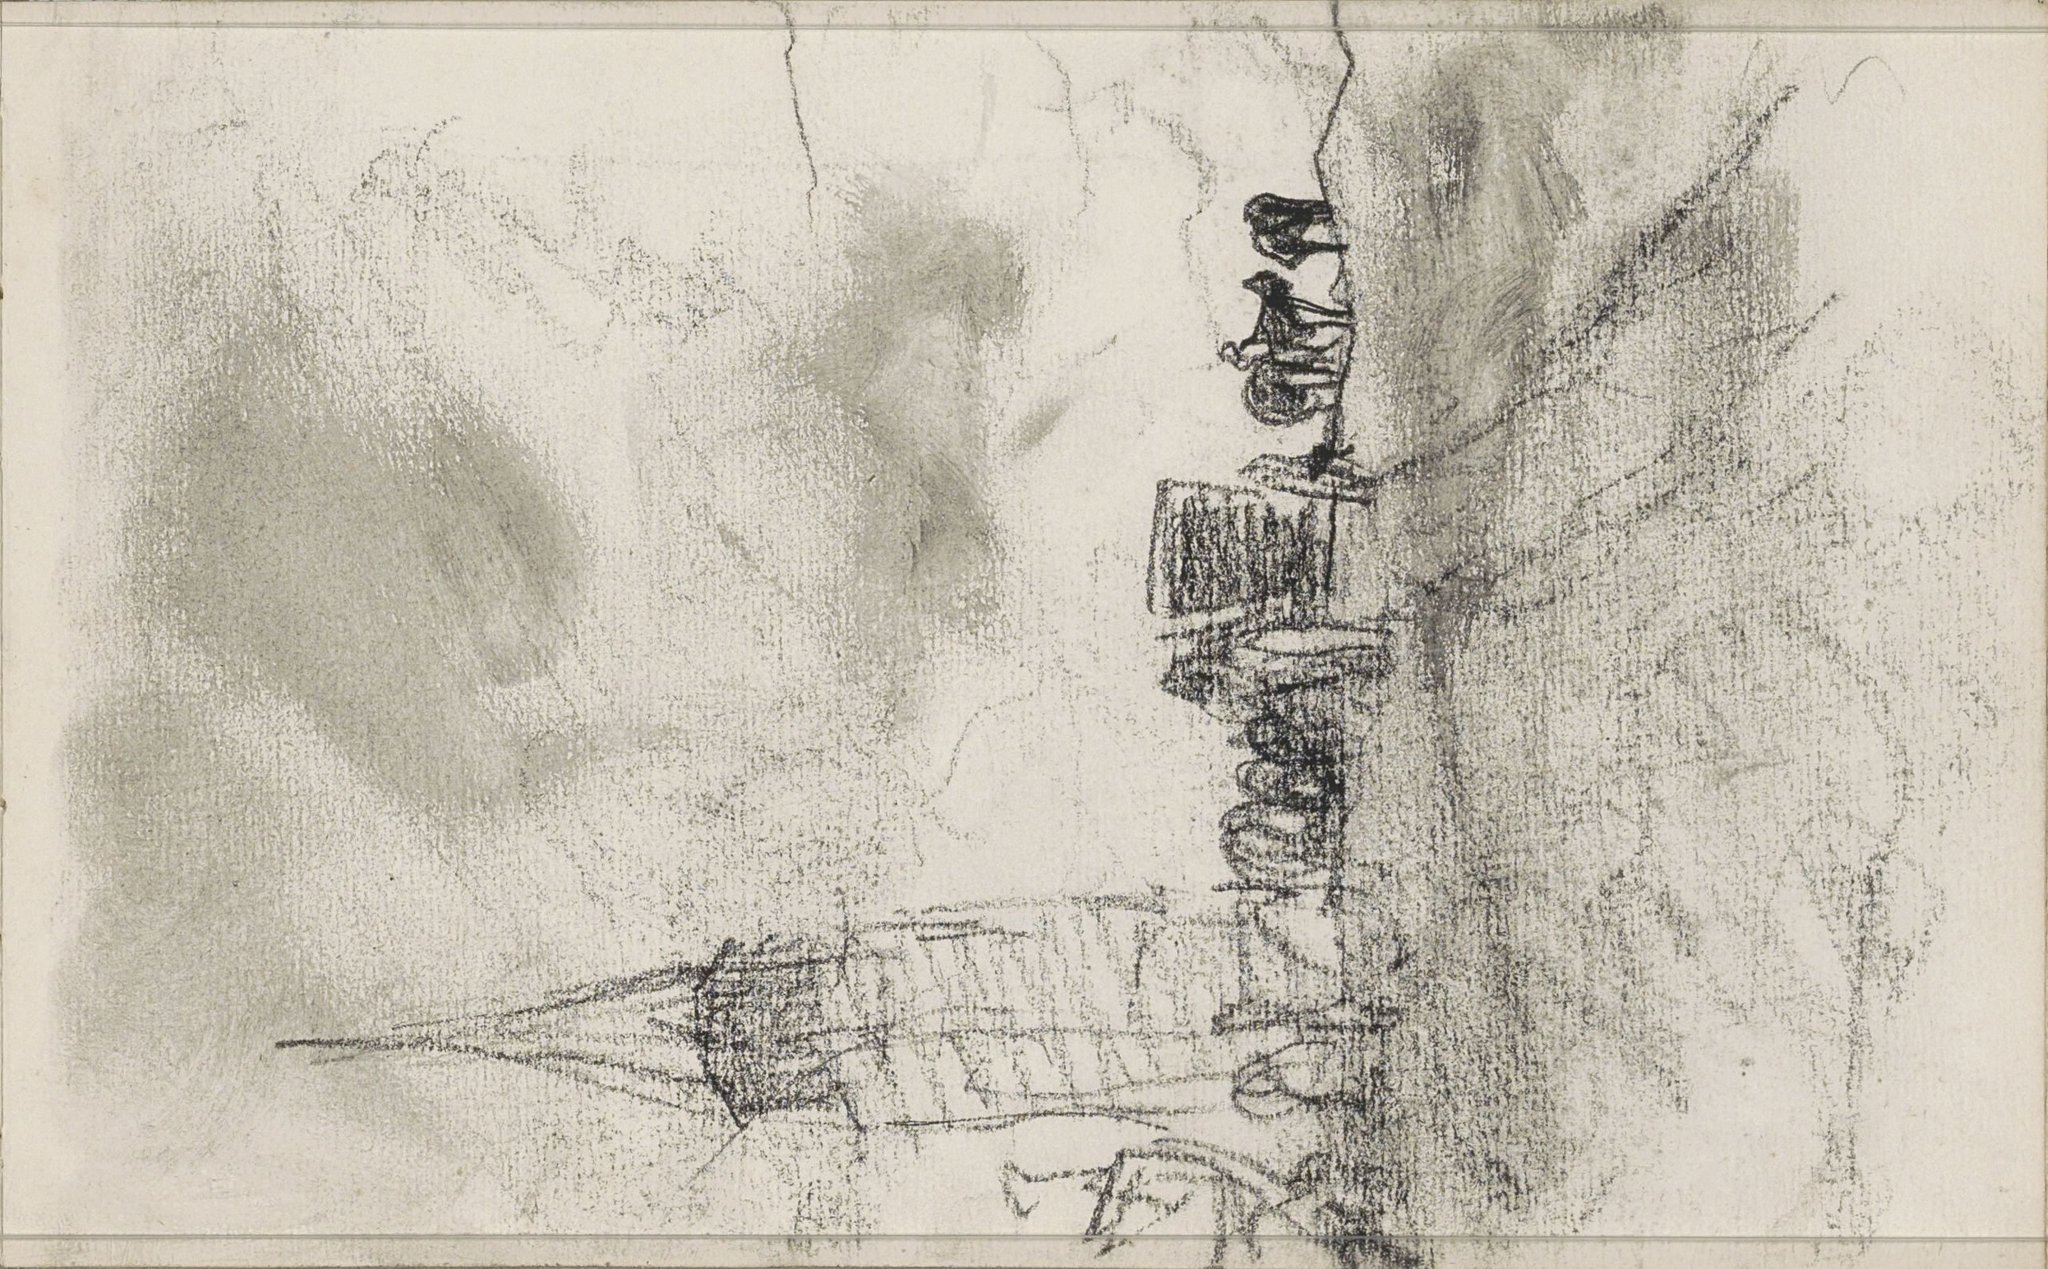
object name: sketchbook leaf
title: Ruiters en een paardenkar bij een toren op een heuvel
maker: anton mauve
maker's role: draughtsman, painter, print maker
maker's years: 1838-1888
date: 1848-1888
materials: chalk, paper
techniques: brush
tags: animal traction, animal-drawn vehicle (carriage etc.), landscape with tower or castle, horse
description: Blad 38 recto uit een schetsboek met 41 bladen.